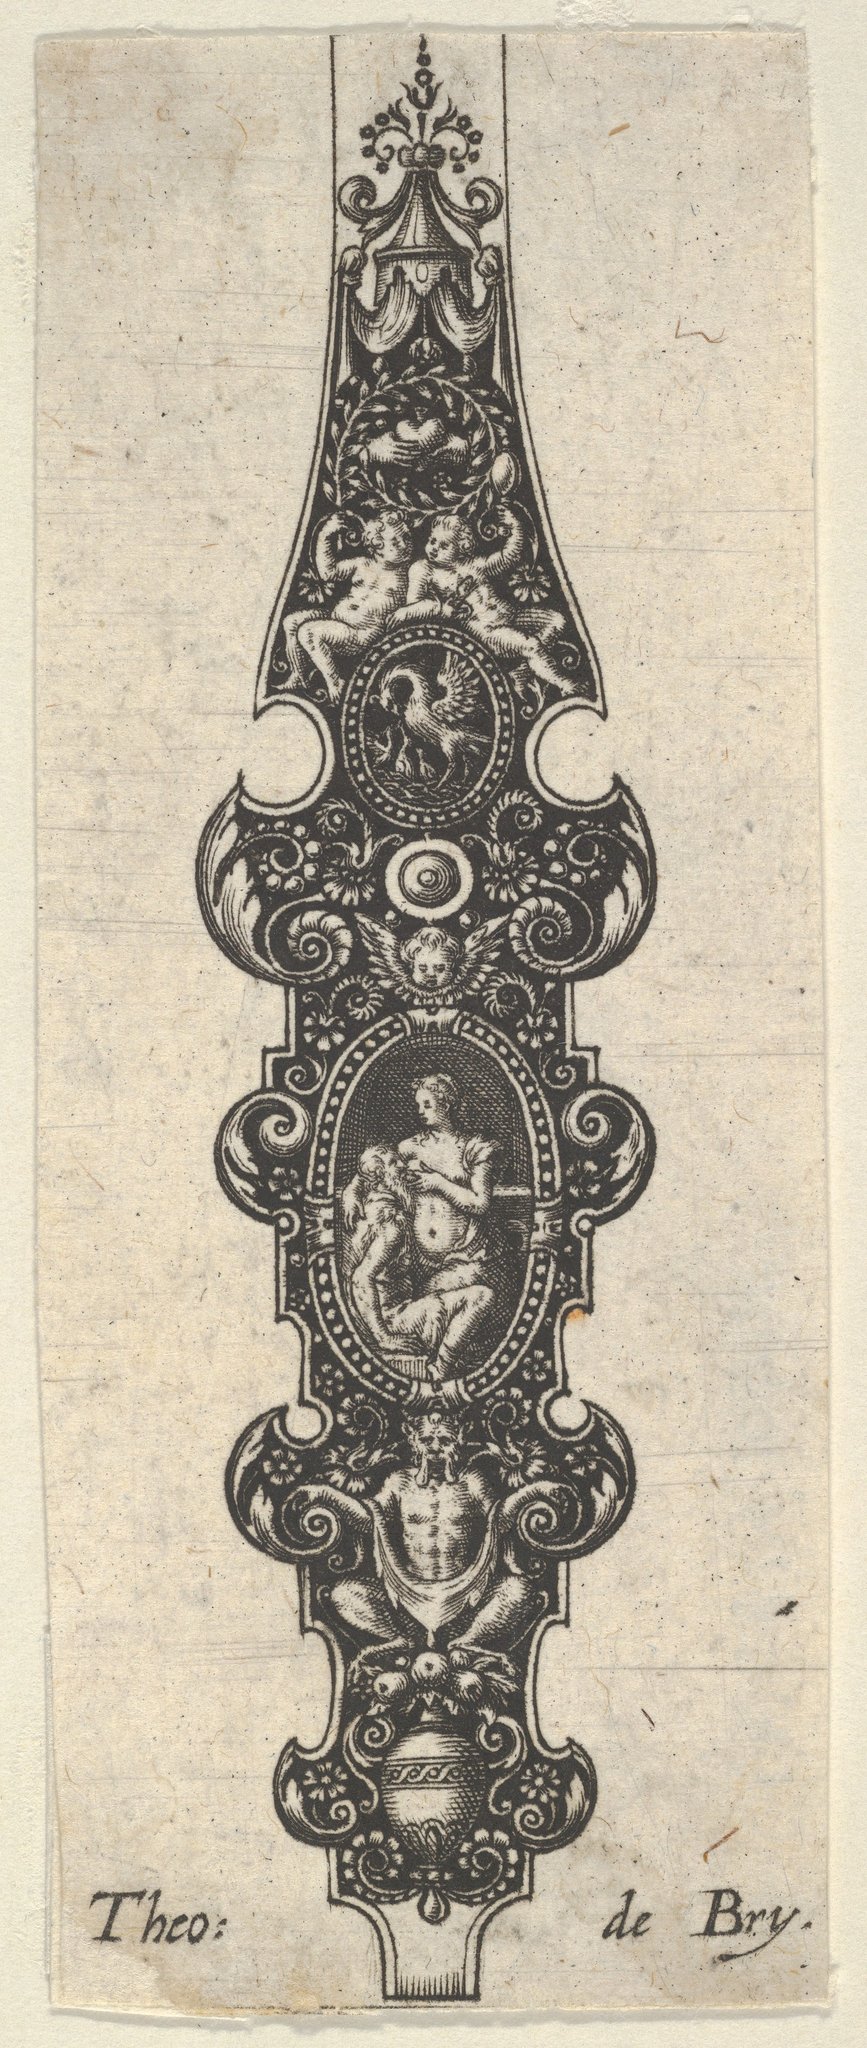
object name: print ornament architecture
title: Pendant Design with Cimon and Pero, from Des Pendants de Cleffs pour les Femmes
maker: johann theodor de bry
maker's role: artist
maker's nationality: netherlandish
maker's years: 1561-1623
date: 1580-1600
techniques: embroidery, engraving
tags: birds,princesses,men,satyrs,vases